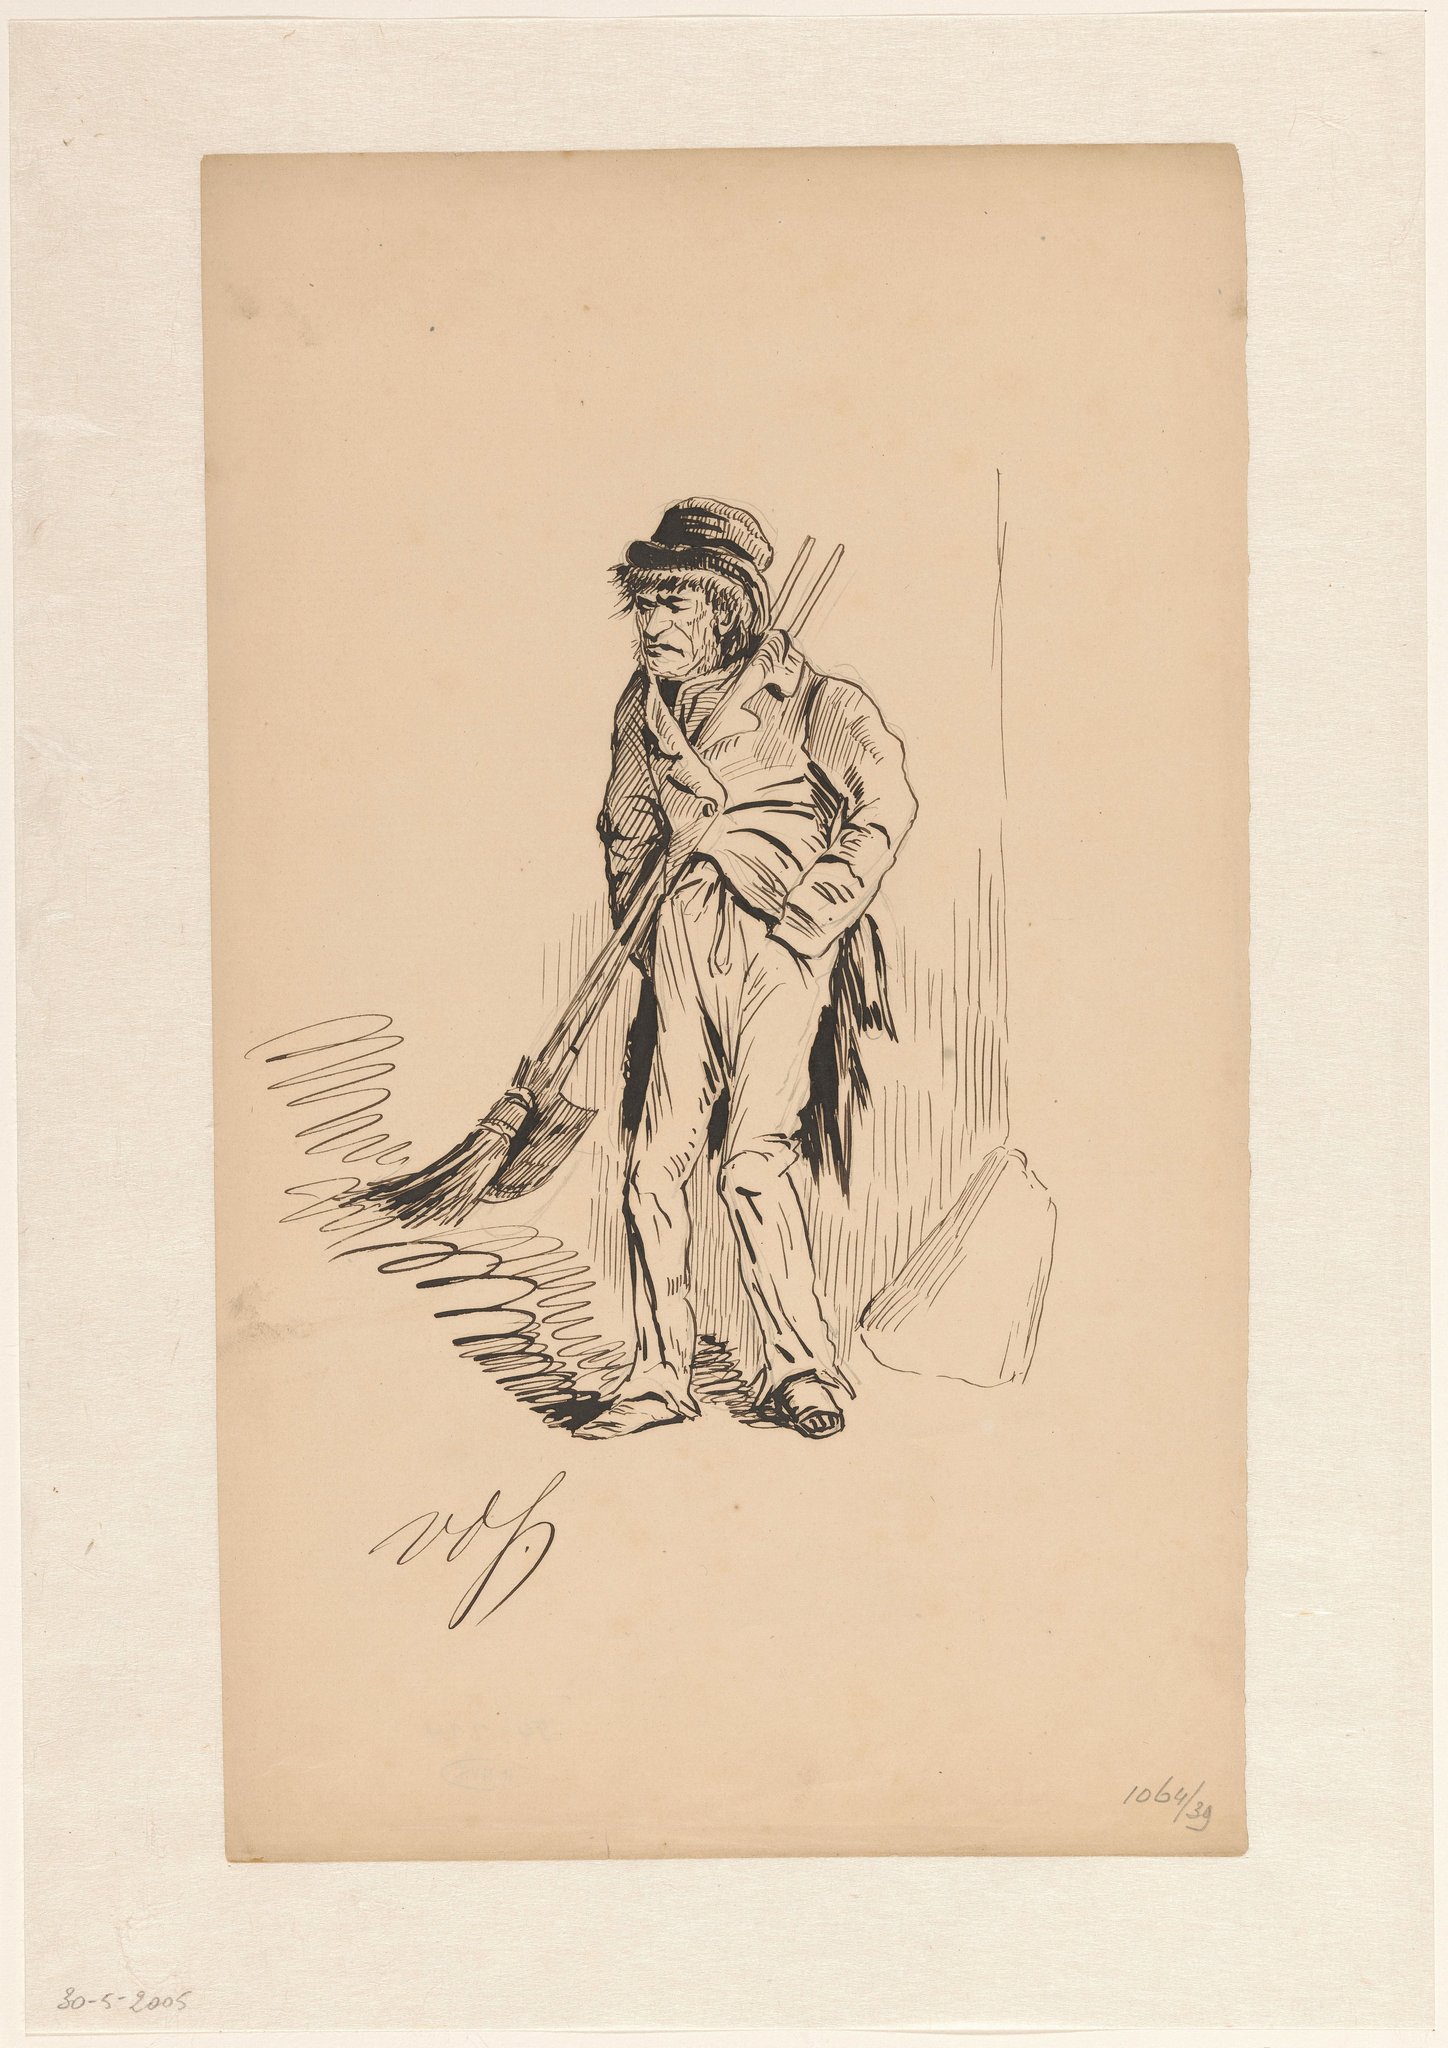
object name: drawing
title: Straatveger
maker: monogrammist vdg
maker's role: draughtsman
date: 1800-1900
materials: ink, paper, pencil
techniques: pen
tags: garbage collection